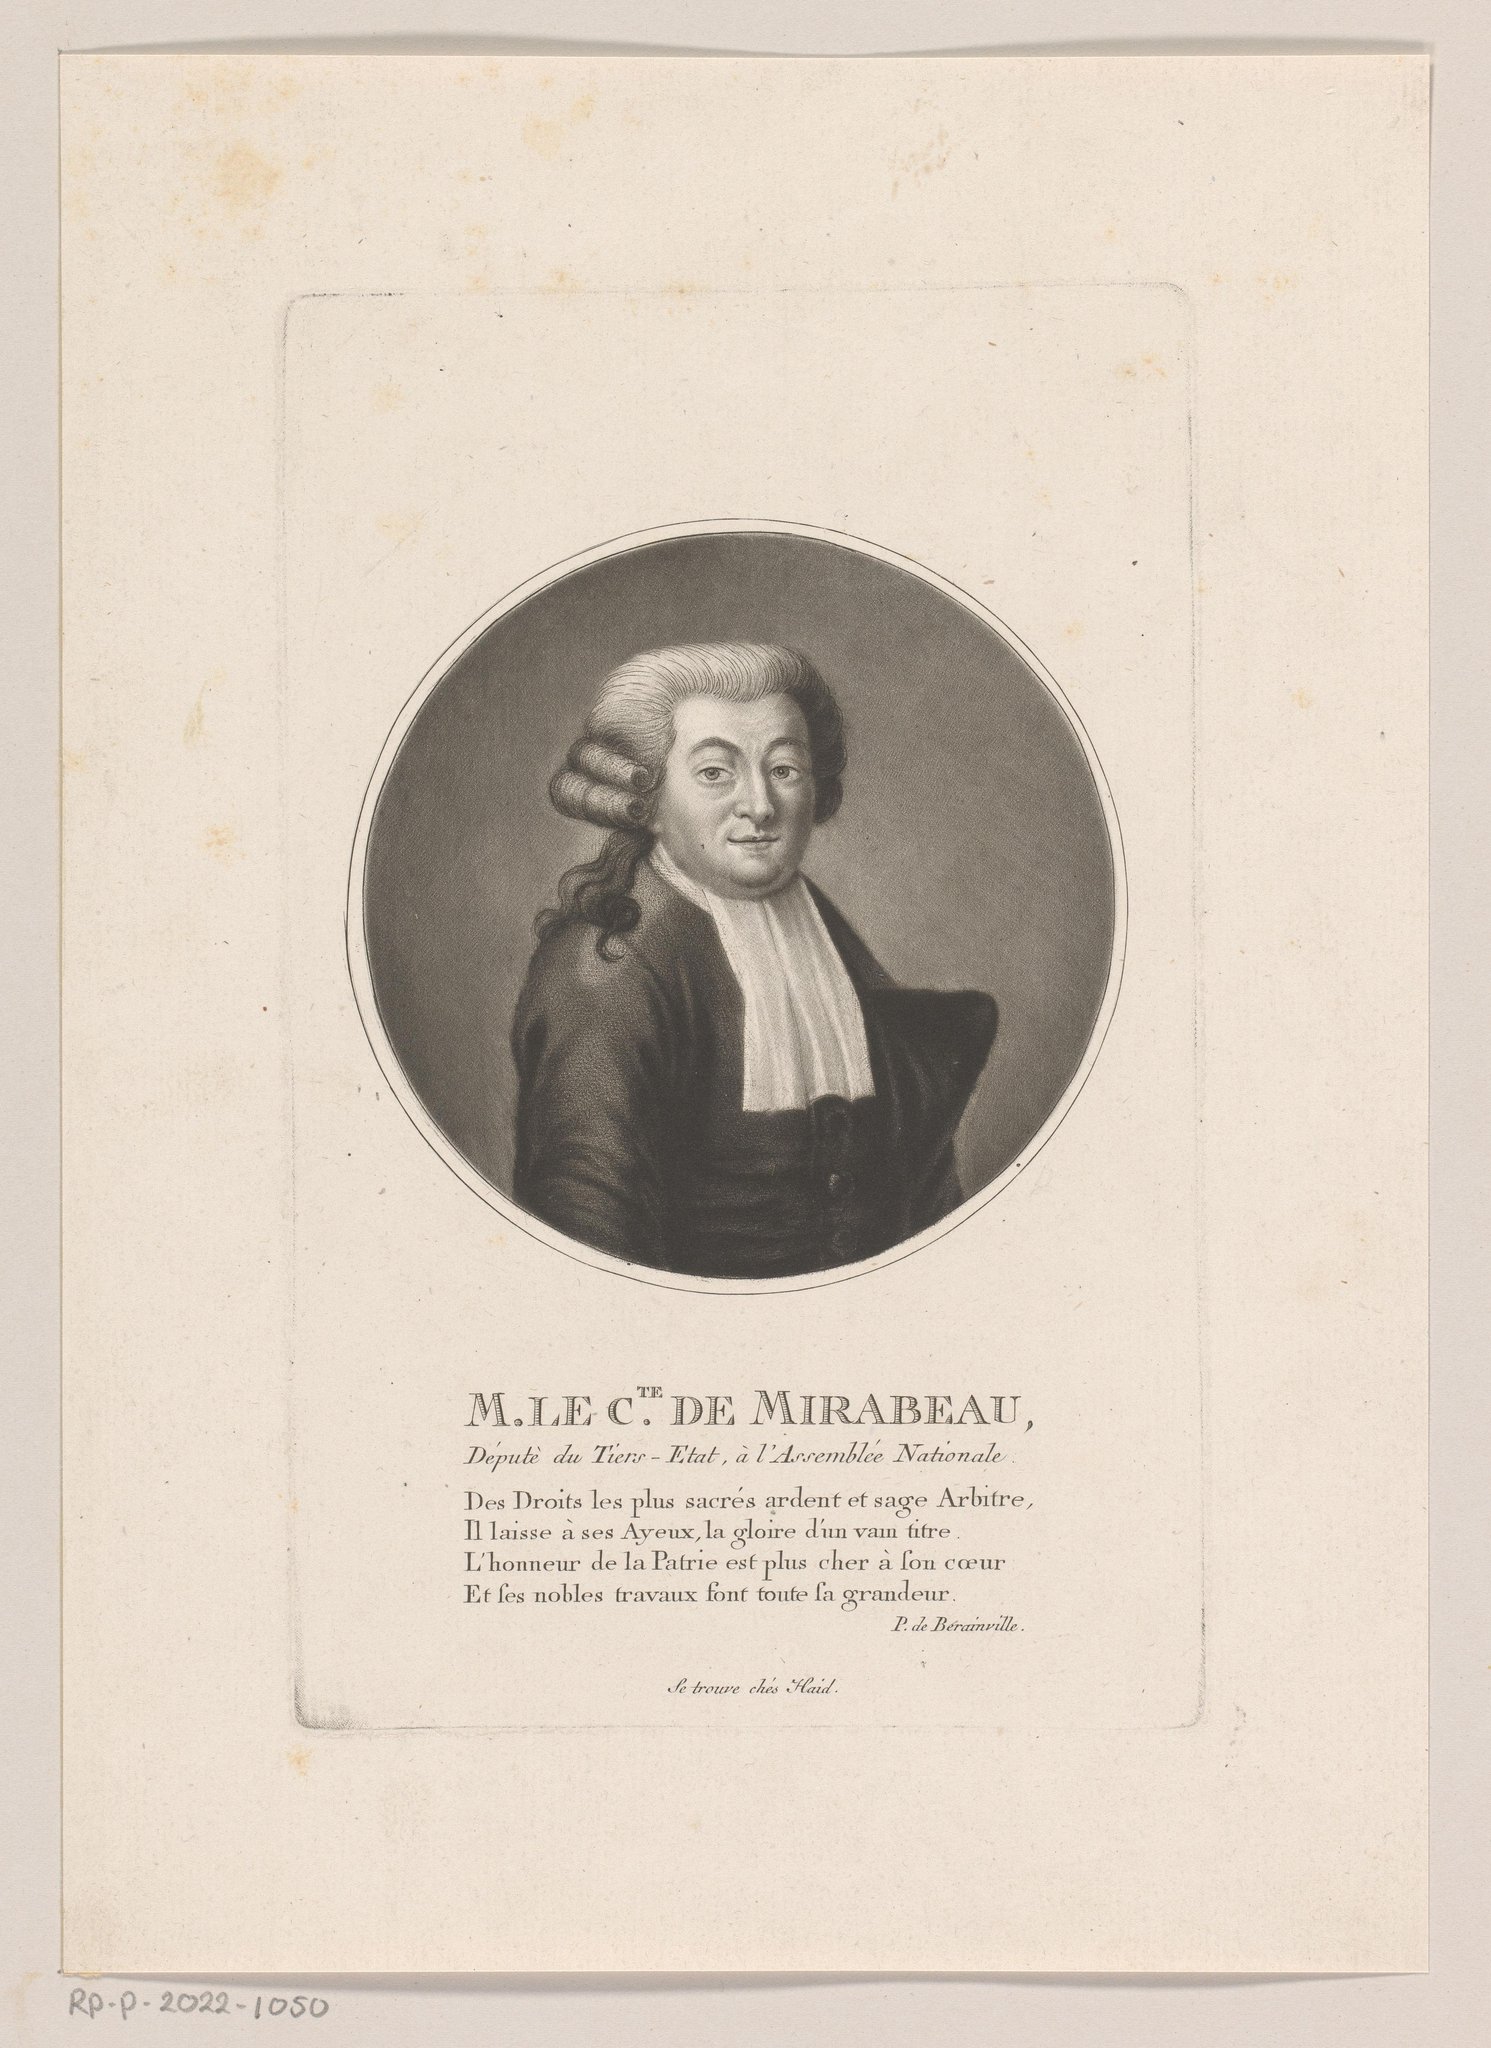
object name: print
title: Portret van Honoré-Gabriel de Riqueti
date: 1780-1850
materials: paper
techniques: engraving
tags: paris, politician, honoré-gabriel de riqueti (graaf van mirabeau), historical persons, ambassador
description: Met vierregelig onderschrift in het Frans.